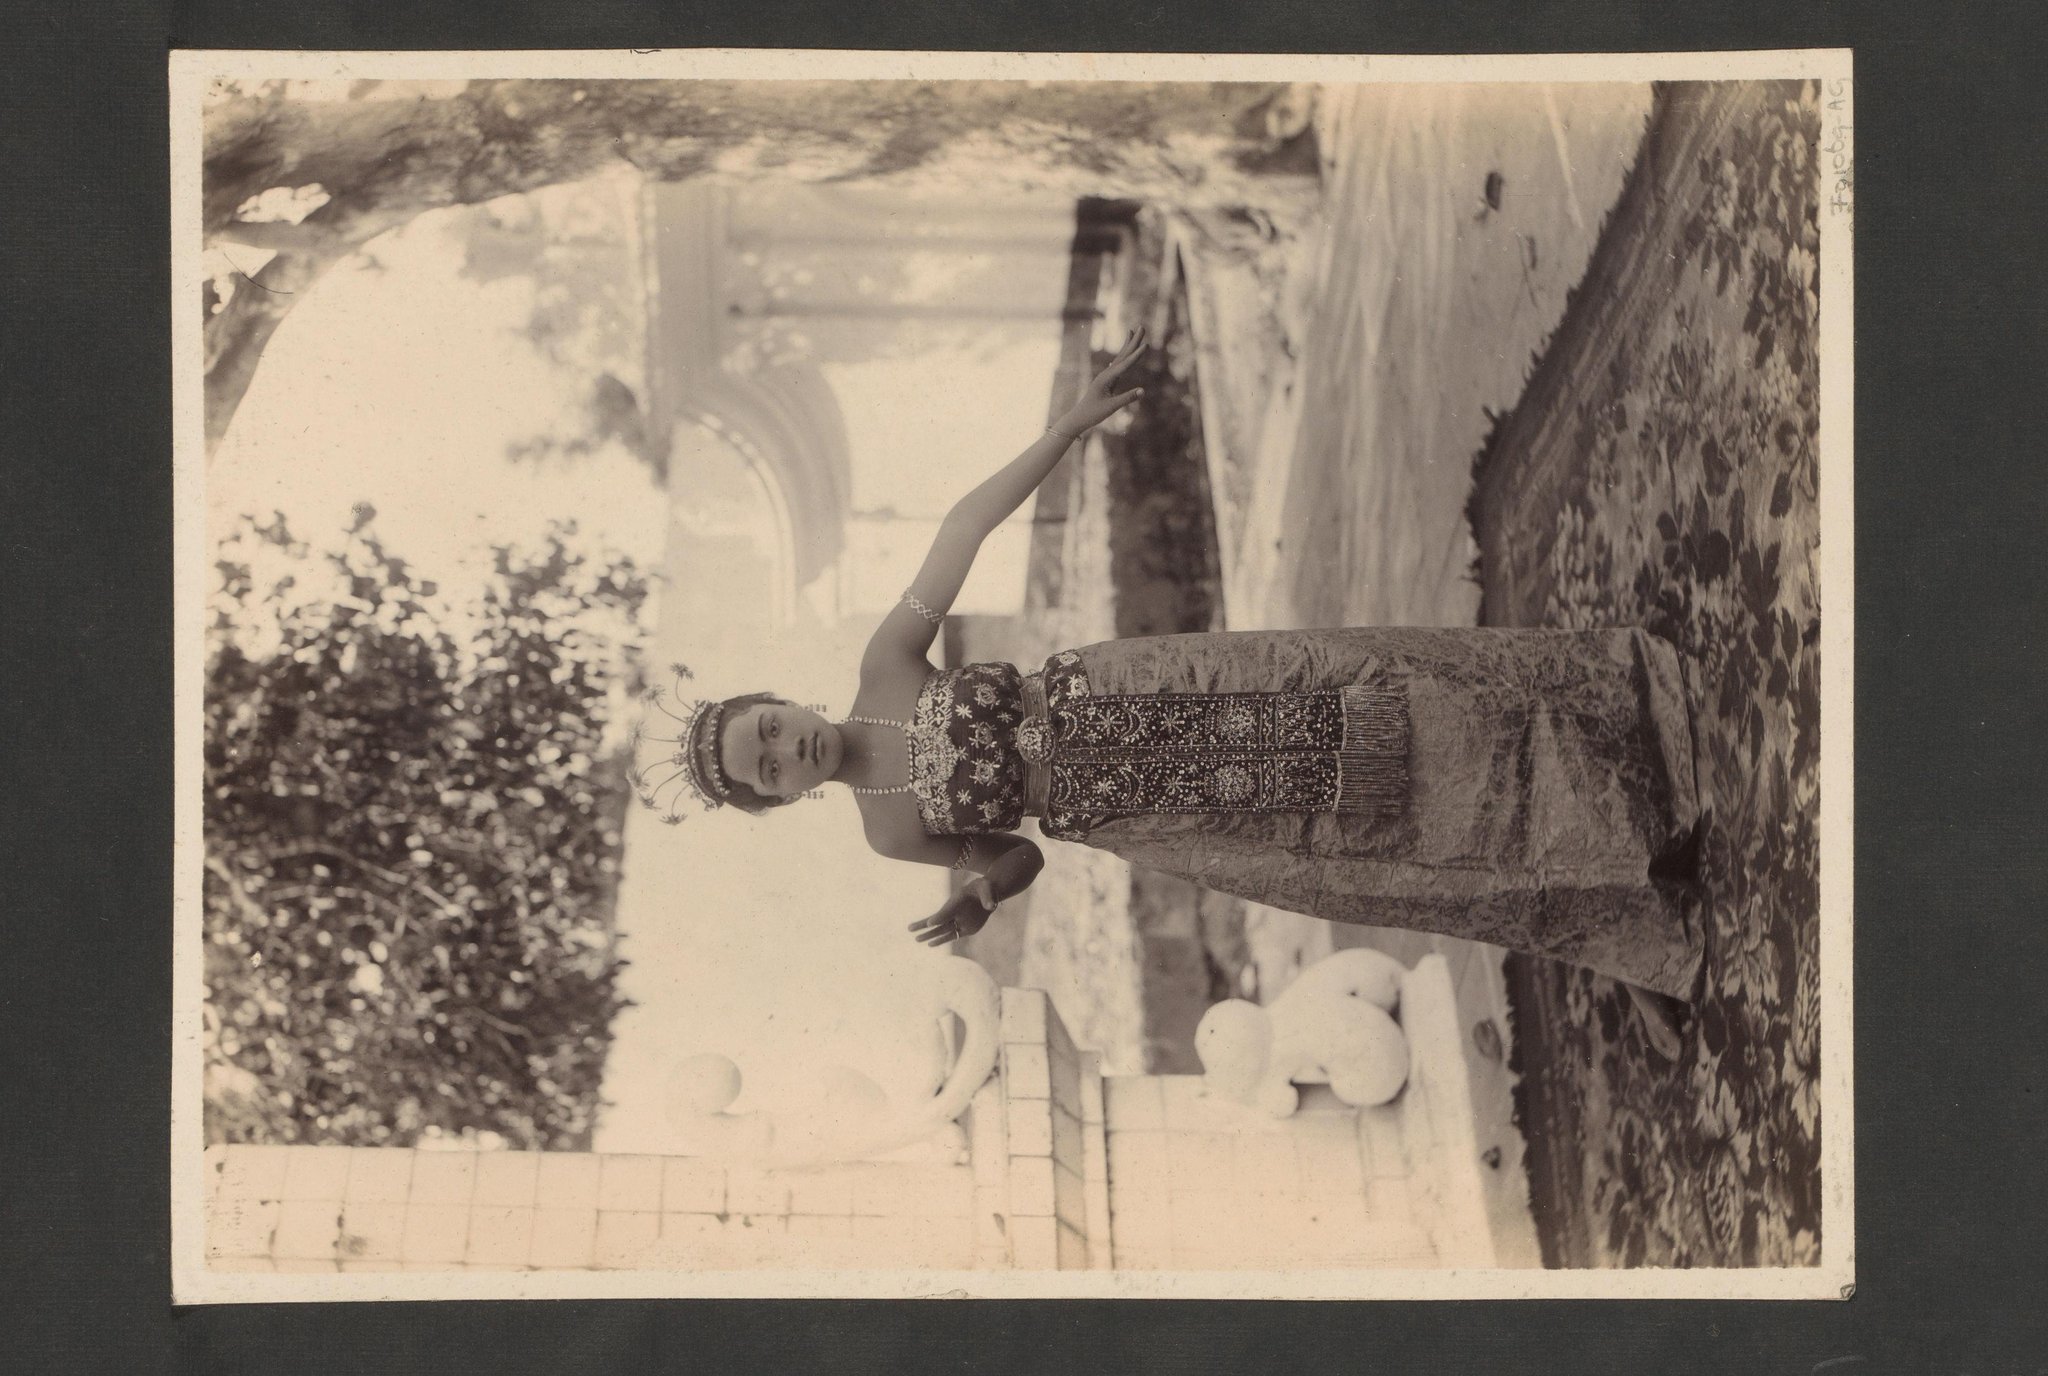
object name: photograph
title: Danseres buiten op een kleed in Nederlands-Indië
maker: onnes kurkdjian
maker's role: fotograaf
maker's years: 1851-1903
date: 1912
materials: paper, photographic support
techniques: gelatin silver print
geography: dutch east indies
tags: portrait of dancer, dutch east indies, the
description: Onderdeel van Reisalbum met veertig foto's van Nederlands-Indië.